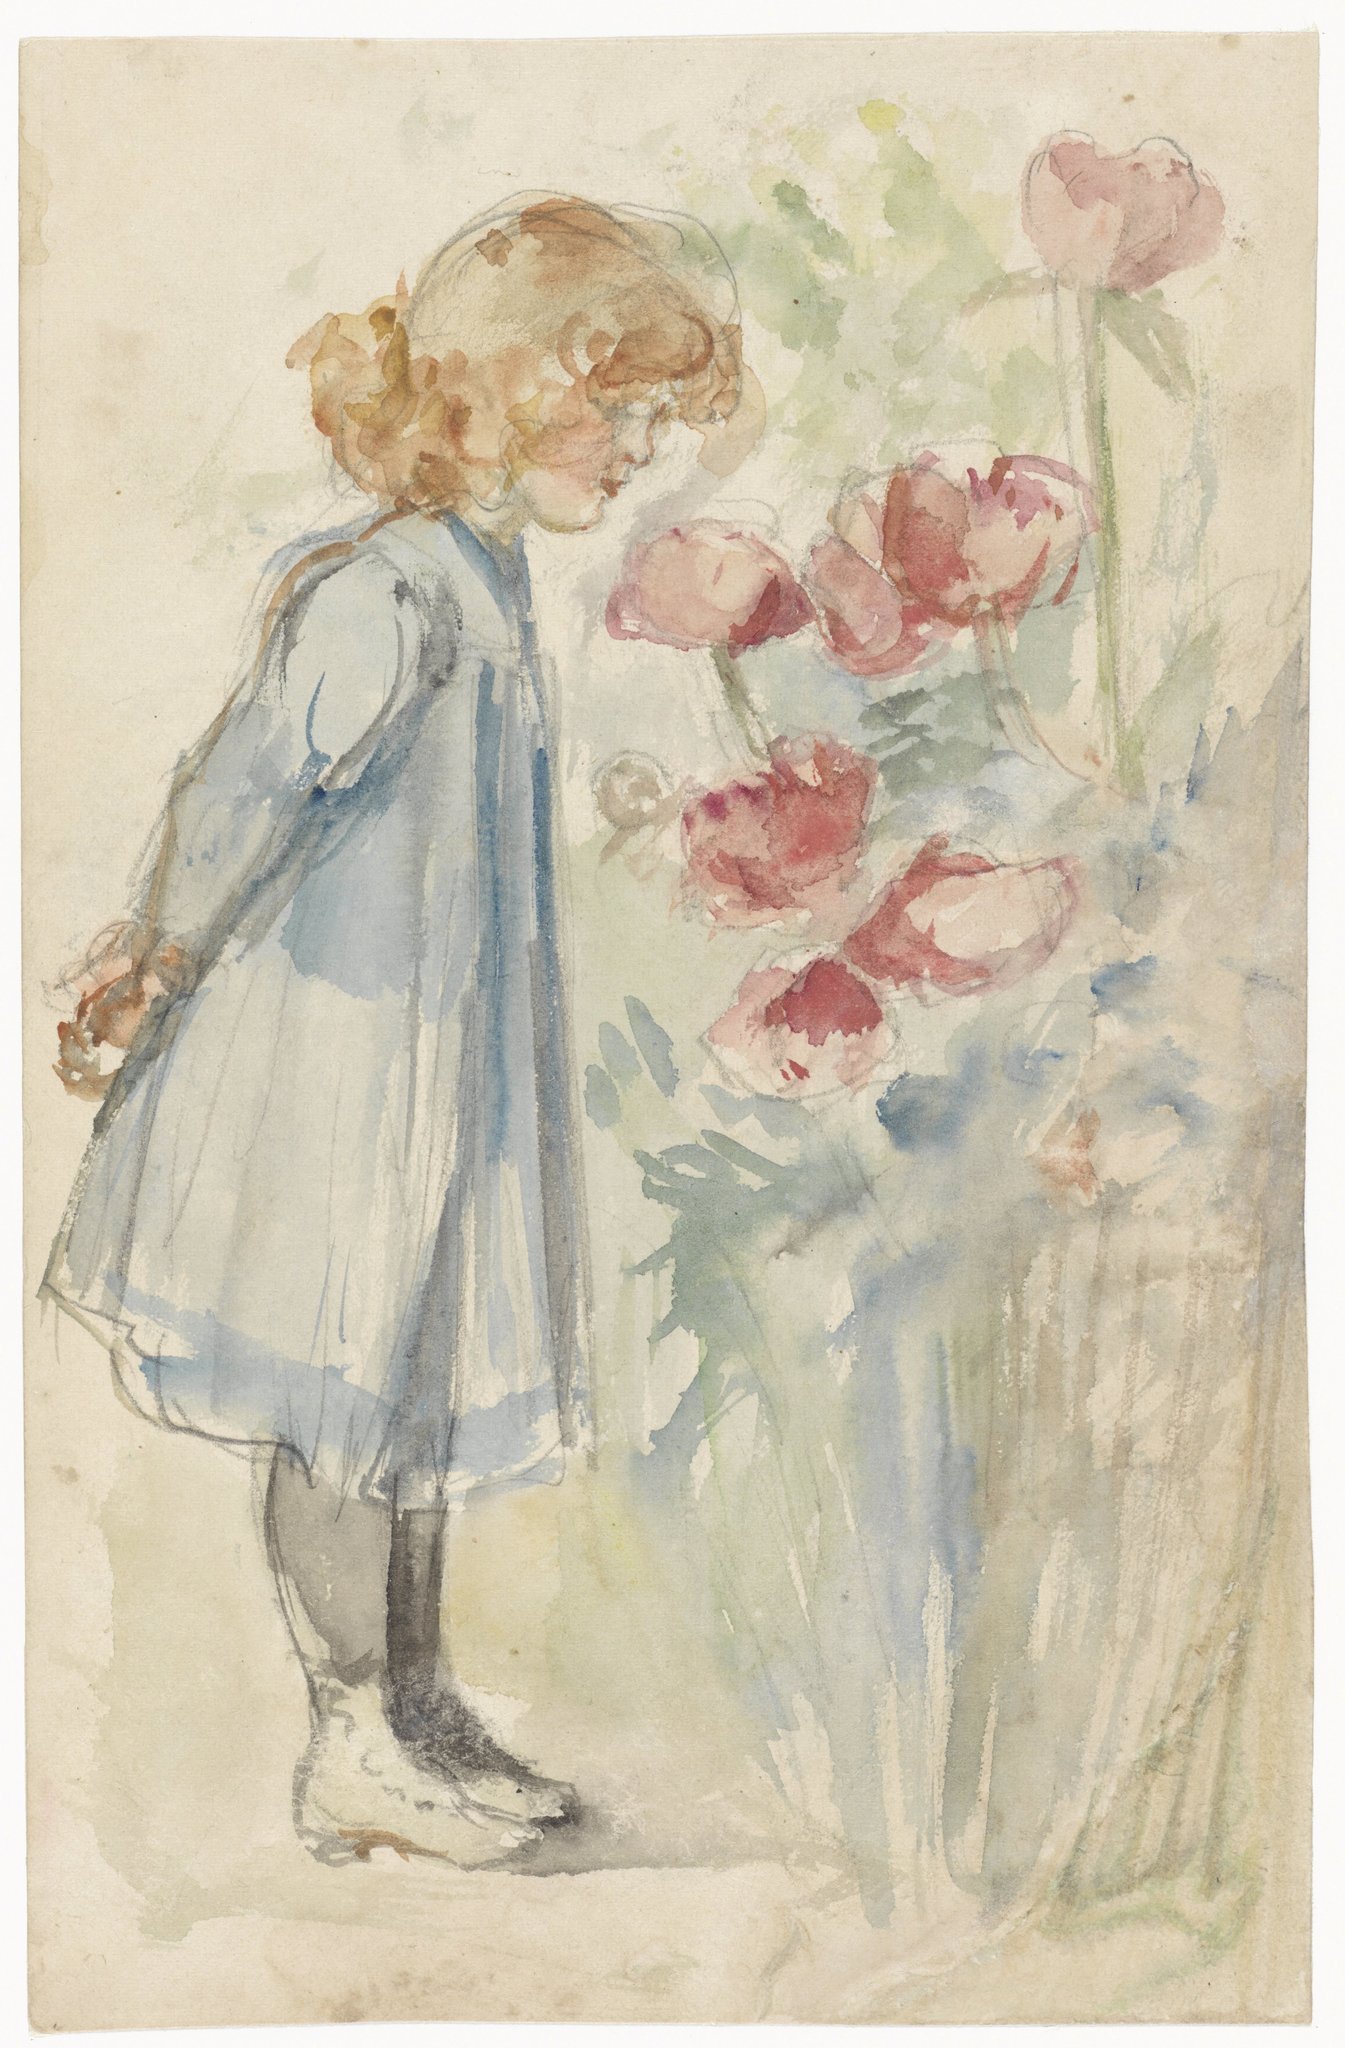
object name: drawing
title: Staand meisje in bloementuin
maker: jozef israëls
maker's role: draughtsman, painter, print maker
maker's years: 1824-1911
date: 1834-1911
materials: paper, pencil, watercolor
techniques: brush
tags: flower-bed